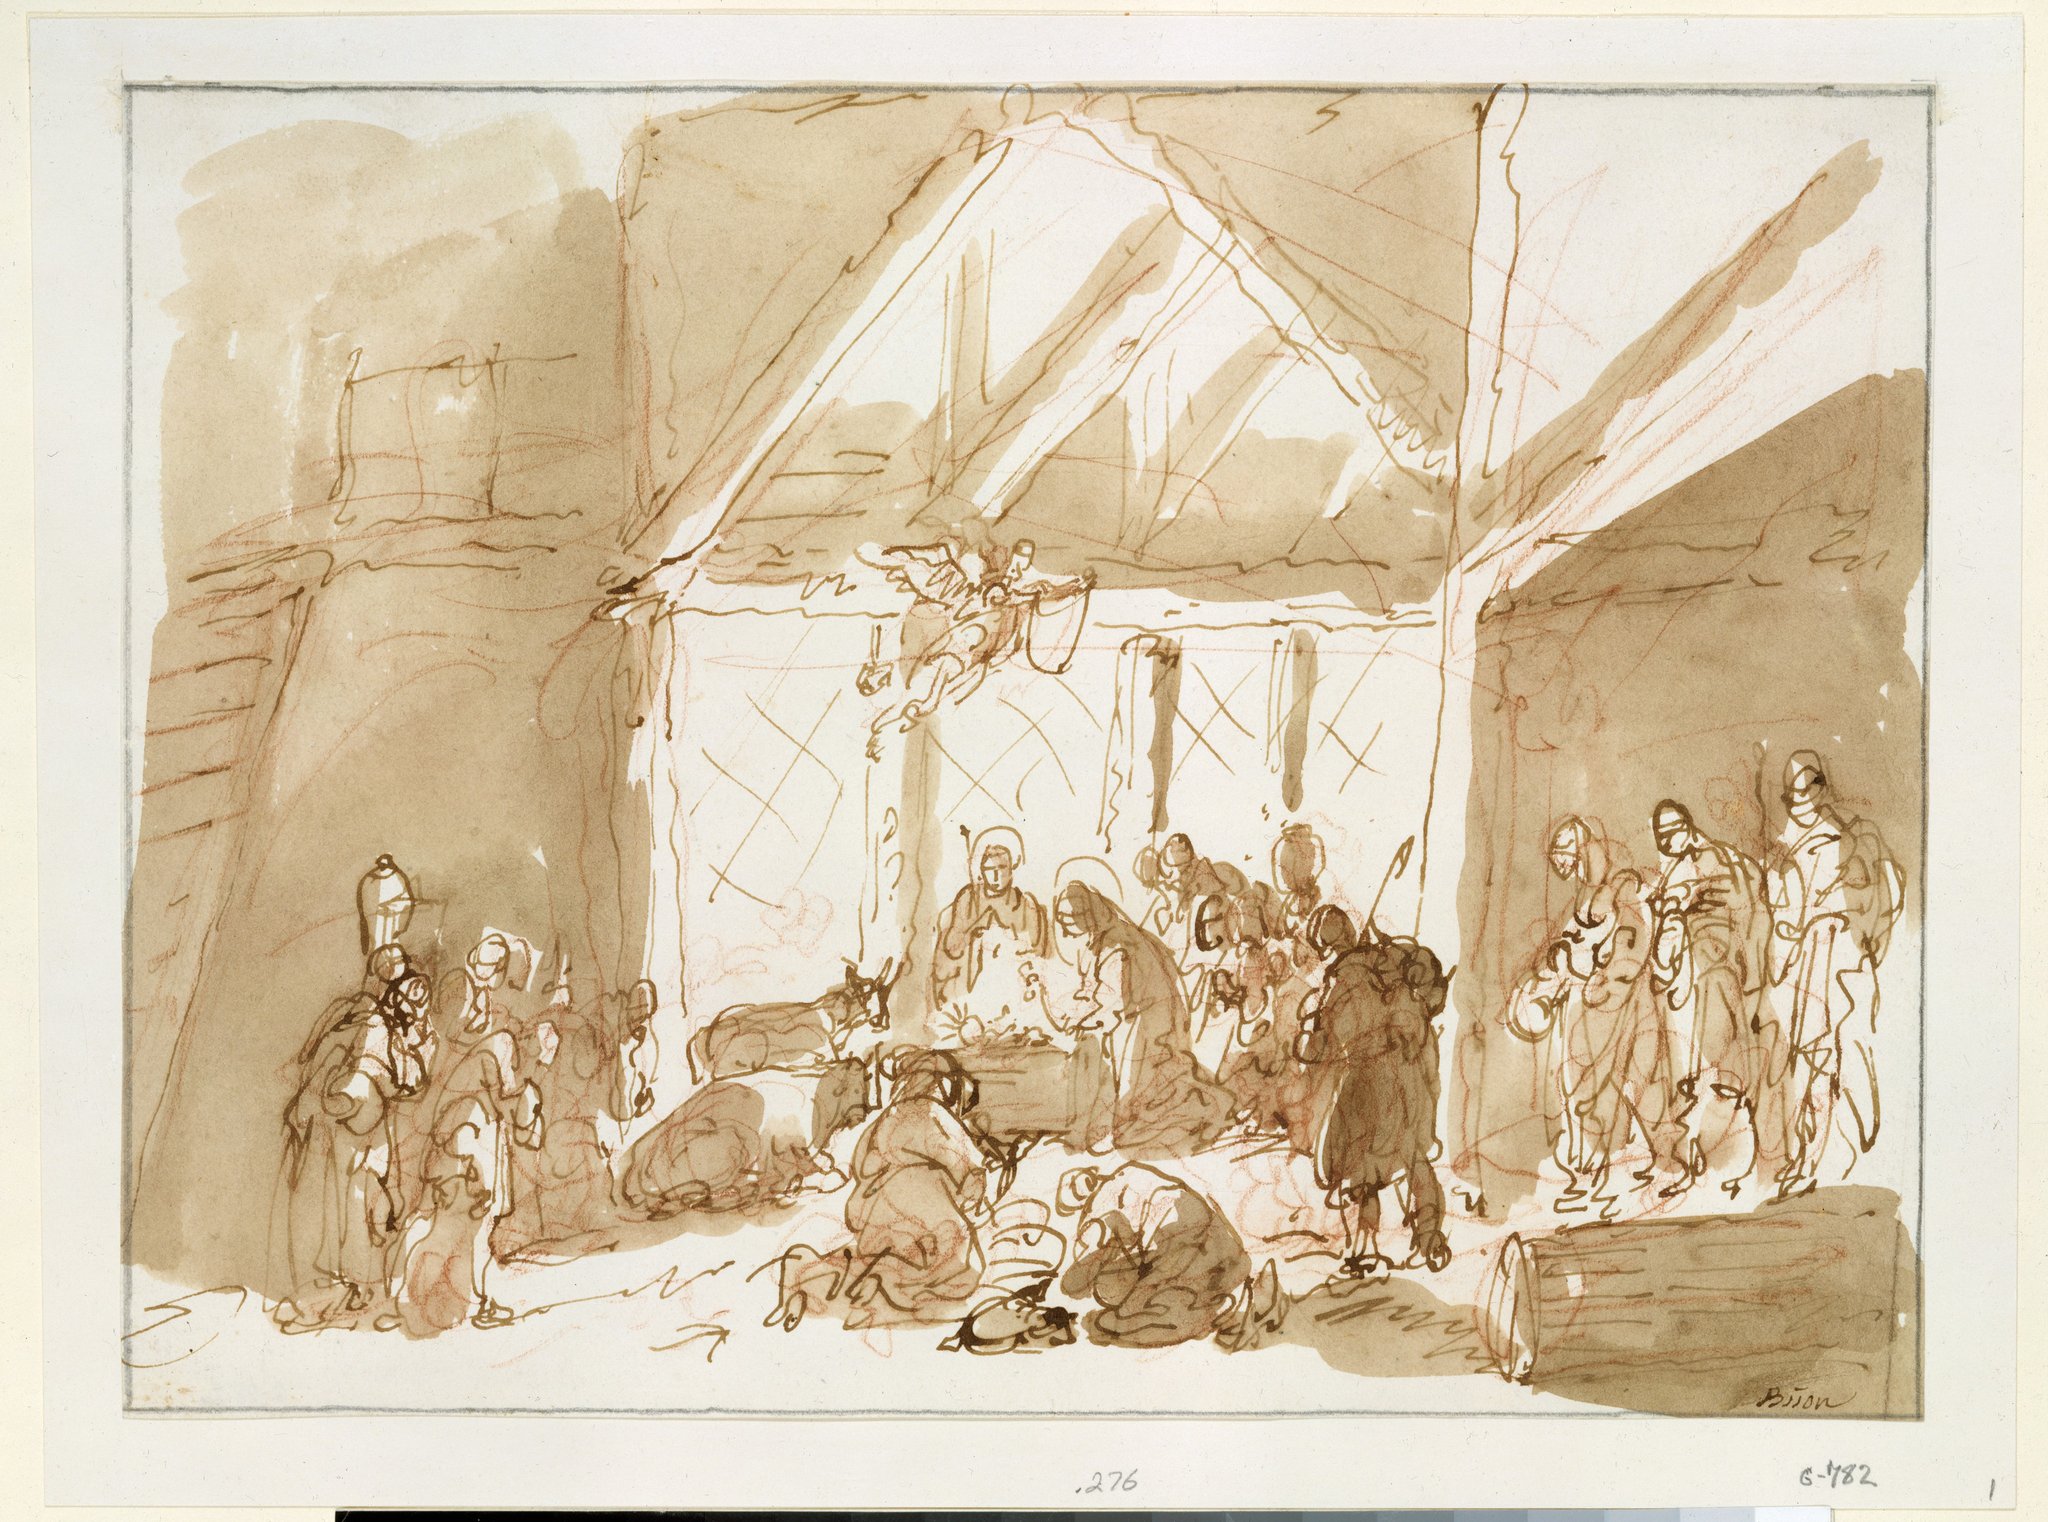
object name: drawing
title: The Nativity of Christ, with Shepherds and Kings in Adoration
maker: giuseppe bernardino bison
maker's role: artist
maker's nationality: italian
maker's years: 1762-1844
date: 1782-1844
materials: chalk, ink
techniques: pen, wash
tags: christ,virgin mary,nativity,saints,shepherds